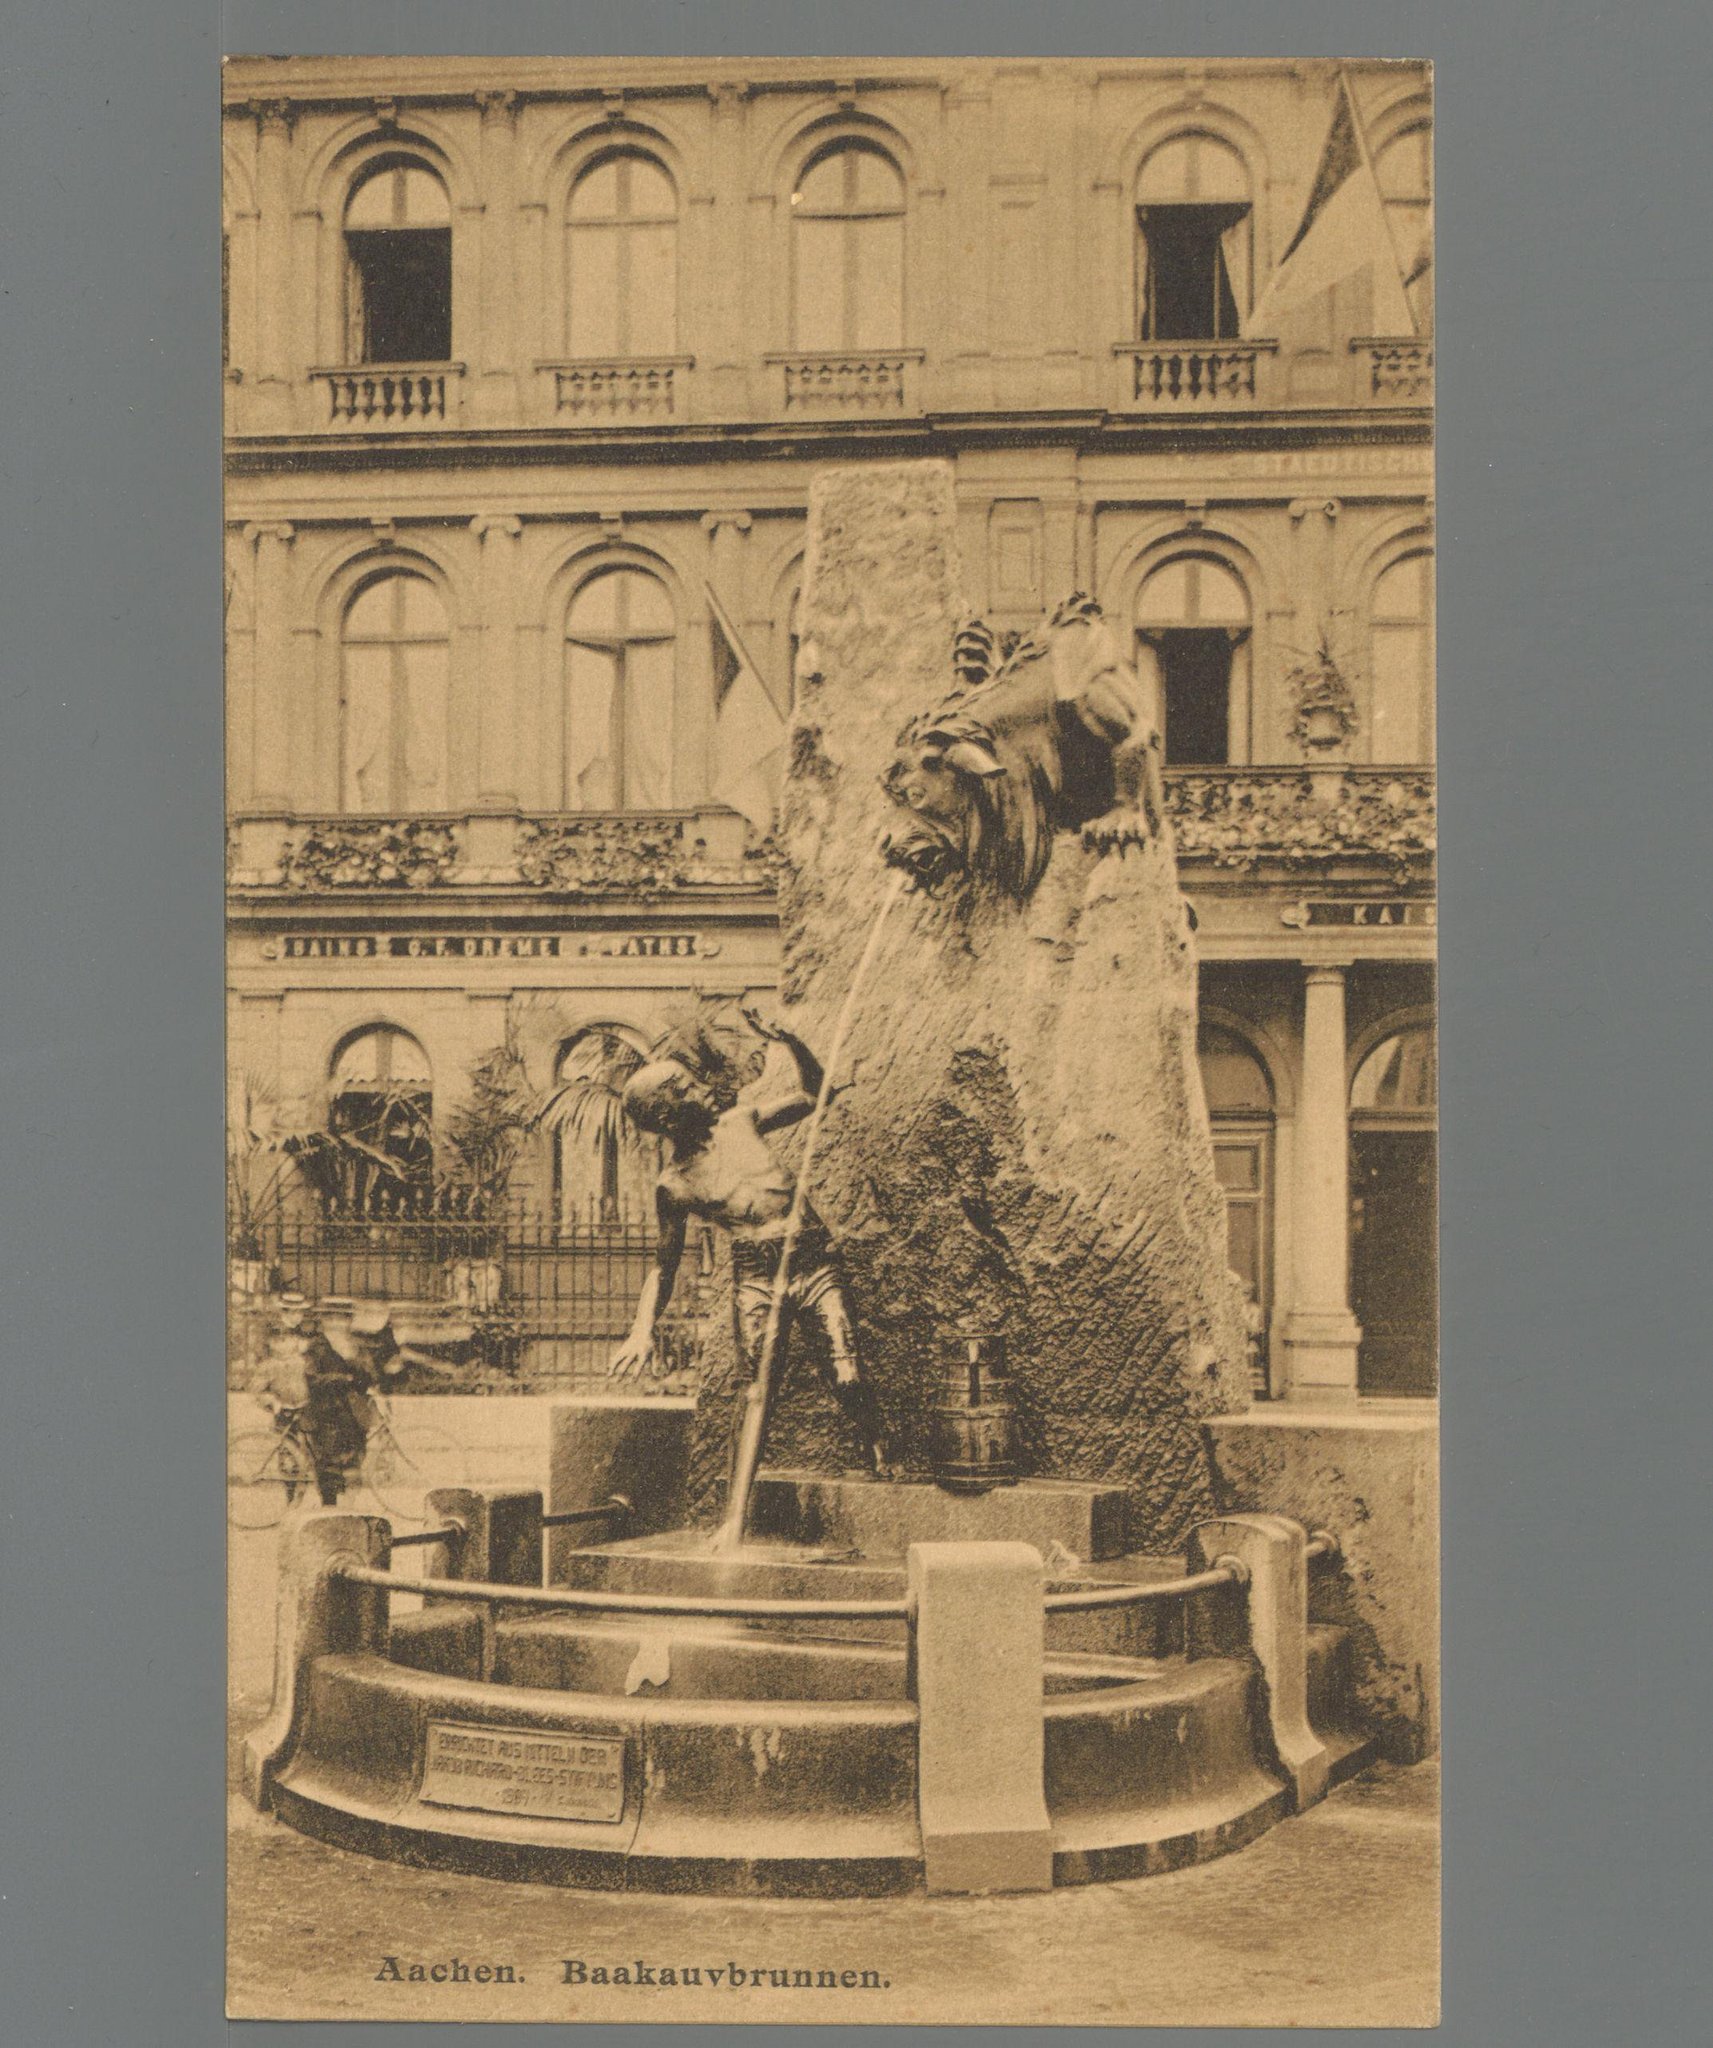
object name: photomechanical print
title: Aachen. Baakauvbrunnen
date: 1905-1910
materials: cardboard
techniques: photograph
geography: aachen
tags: ornamental fountain